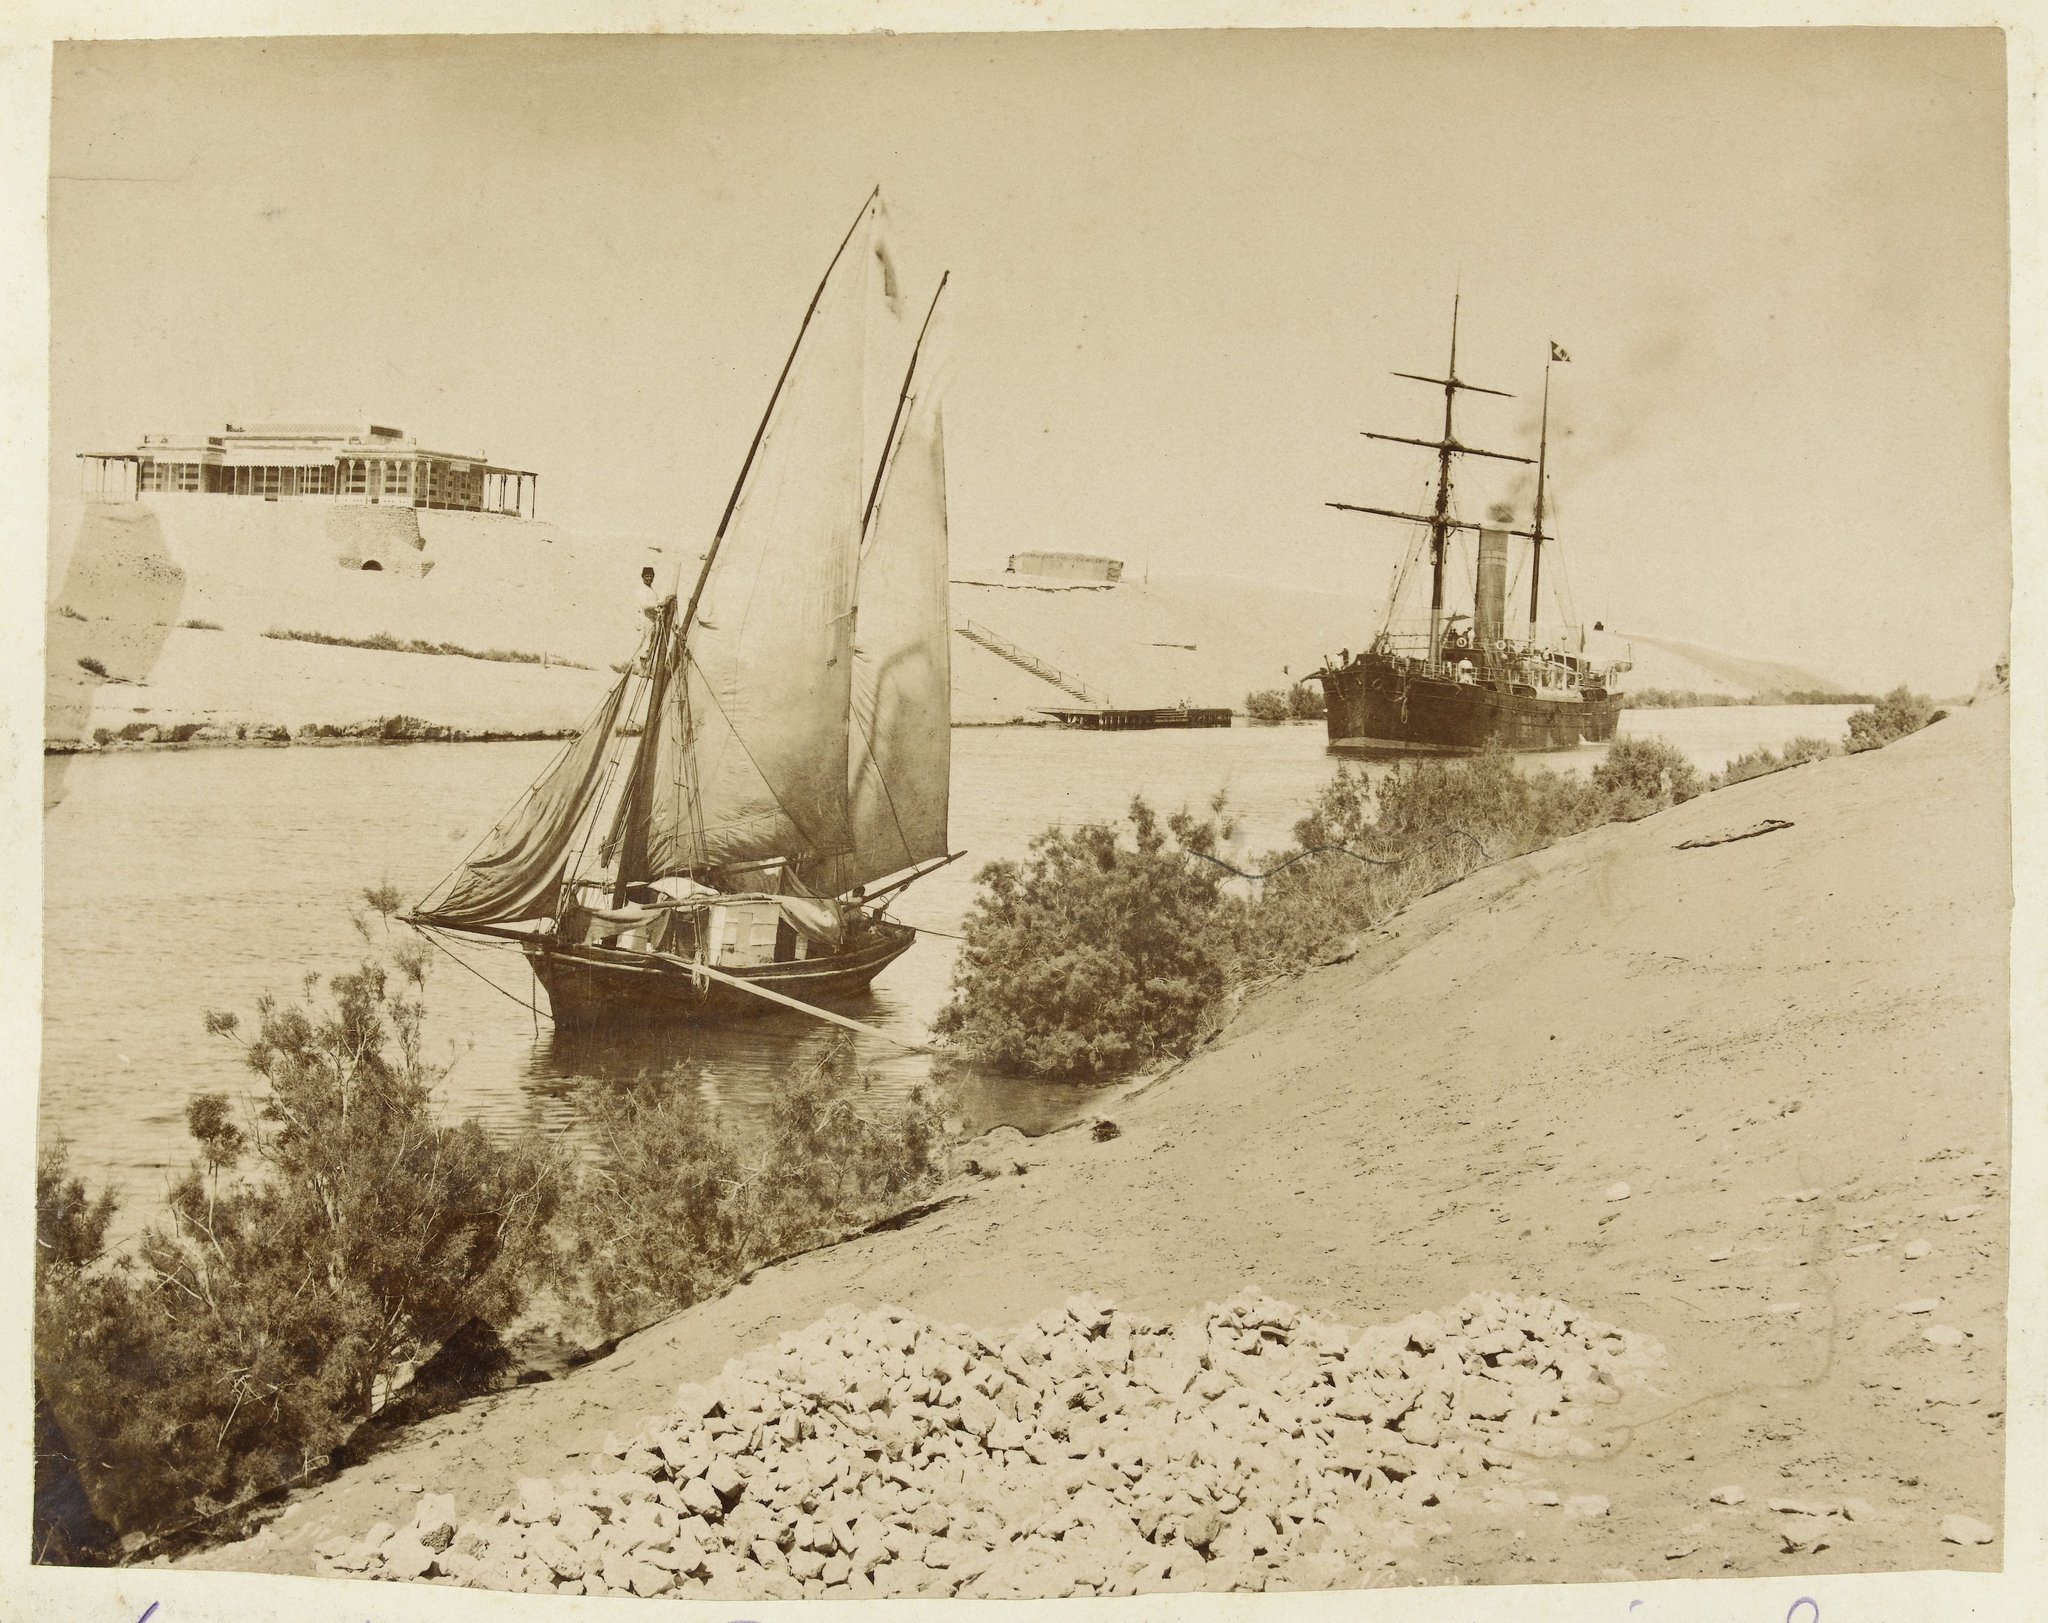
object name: photograph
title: Twee zeilschepen in het Suez kanaal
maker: Anonymous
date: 1890-1910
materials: cardboard, paper, photographic support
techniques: gelatin silver print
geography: netherlands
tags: suezkanaal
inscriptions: caption: ‘Suez kanaal, Pavillon waarin keizerin Eugenie logeerde tijdens de opening van het kanaal’